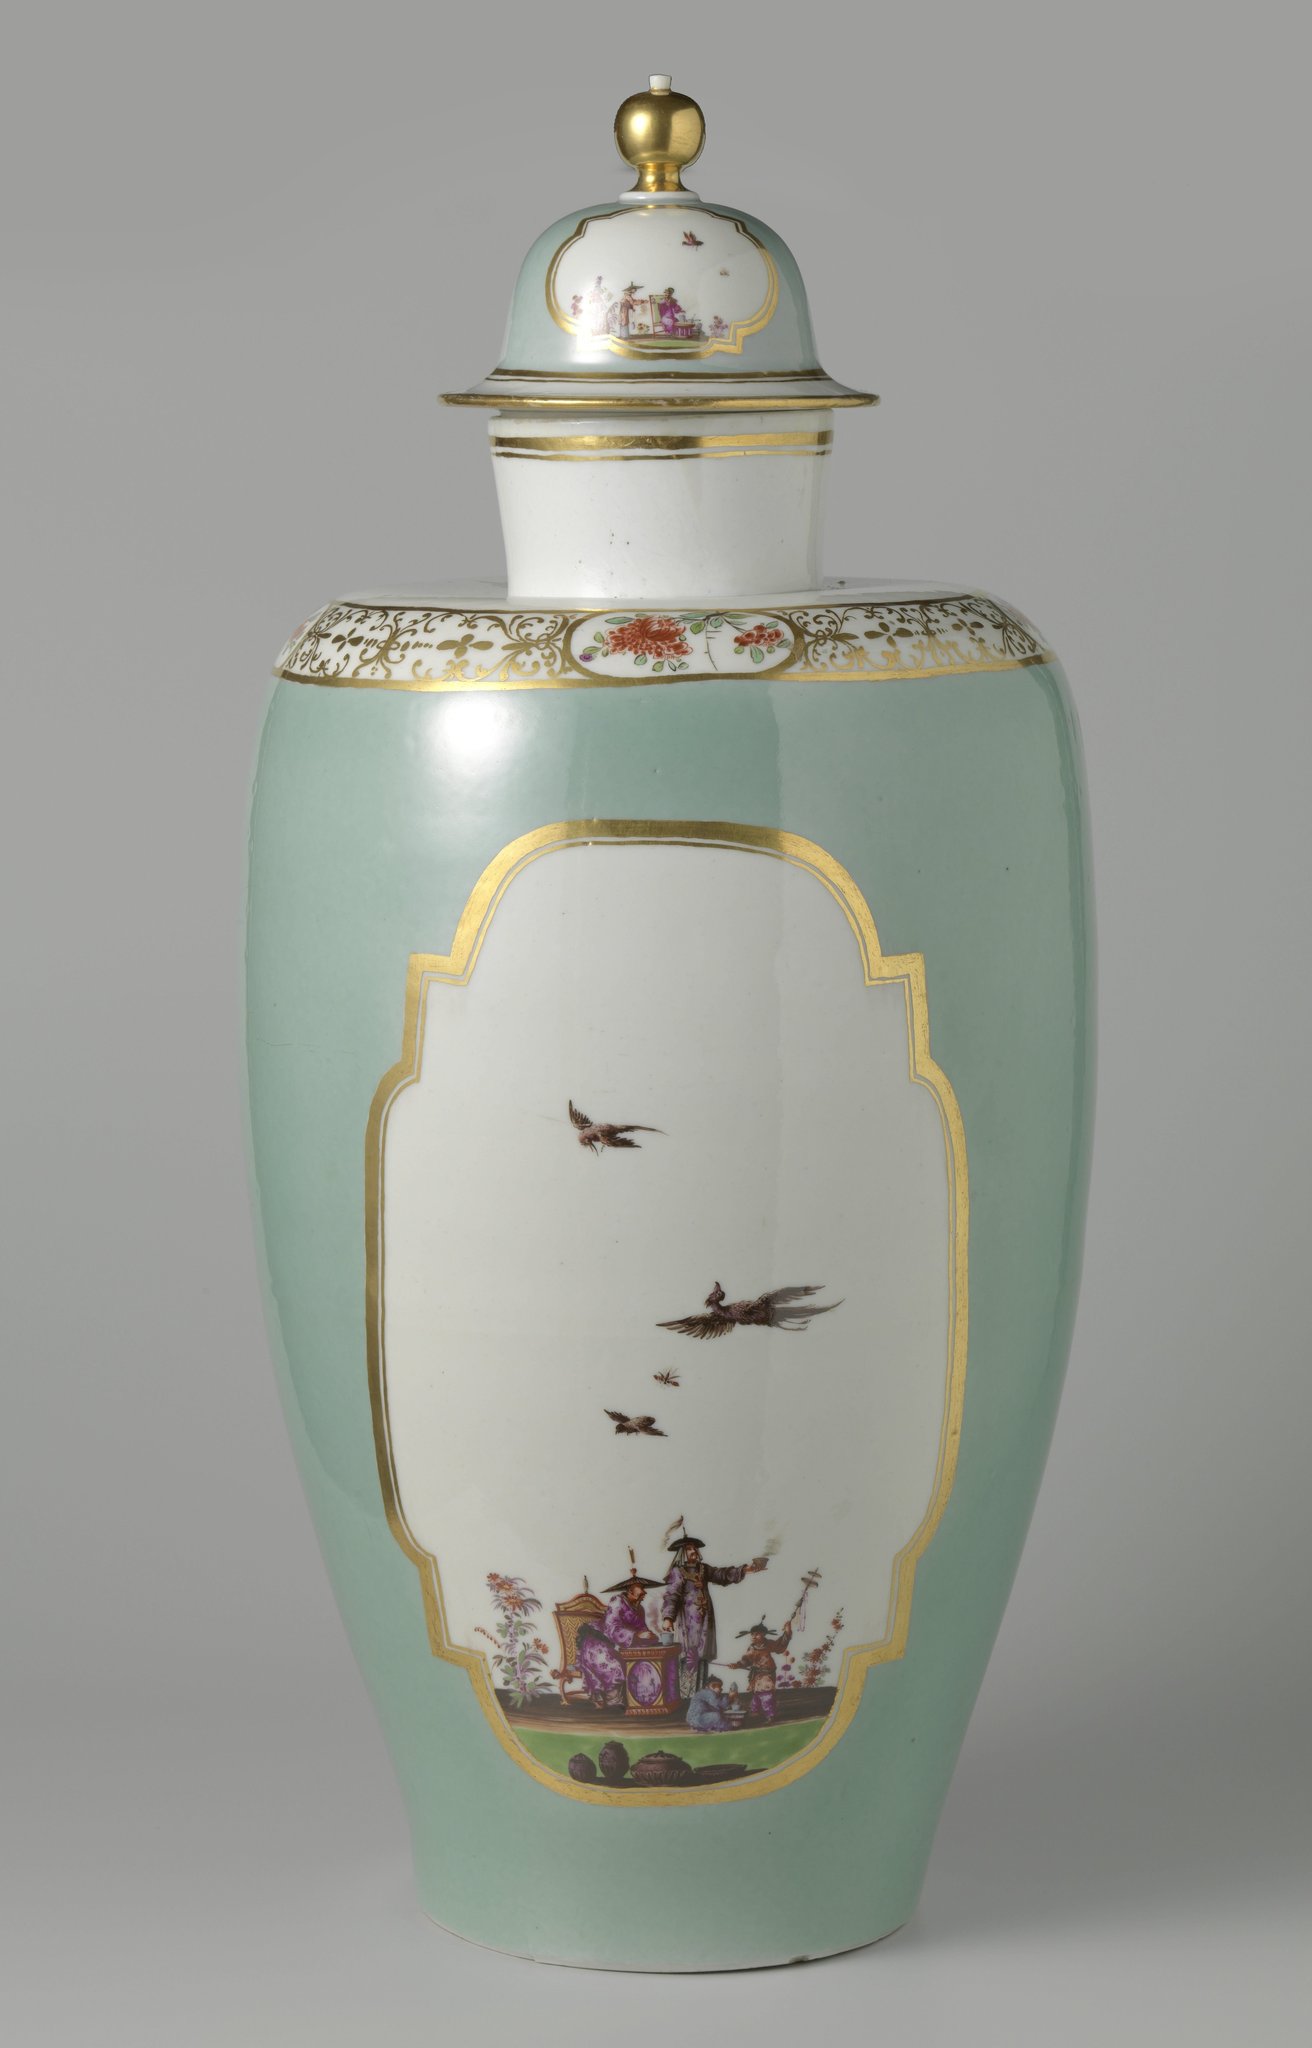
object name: decoratief object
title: Vase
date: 1725-1730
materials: porcelain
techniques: painted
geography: meissen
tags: chinese (+ other cultural aspects)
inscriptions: factory mark: ‘AR’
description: Vaas met deksel, van veelkleurig beschilderd porselein. Vaas en deksel zijn bijna geheel bedekt met een grijze fond, waarin twee hooggerekte accoladevormige vierpassen zijn uitgespaard waarin aan de ene kant Höroldt-chinoiserieën in een tuin en aan de andere kant een tak met Indianische Blumen. Het deksel heeft eveneens twee vierpassen. Op de schouder loopt een ornamentband met bladerwerk en rozetten in goud, viermaal onderbroken door ovalen met Indianische Blumen. De vaas is gemerkt.